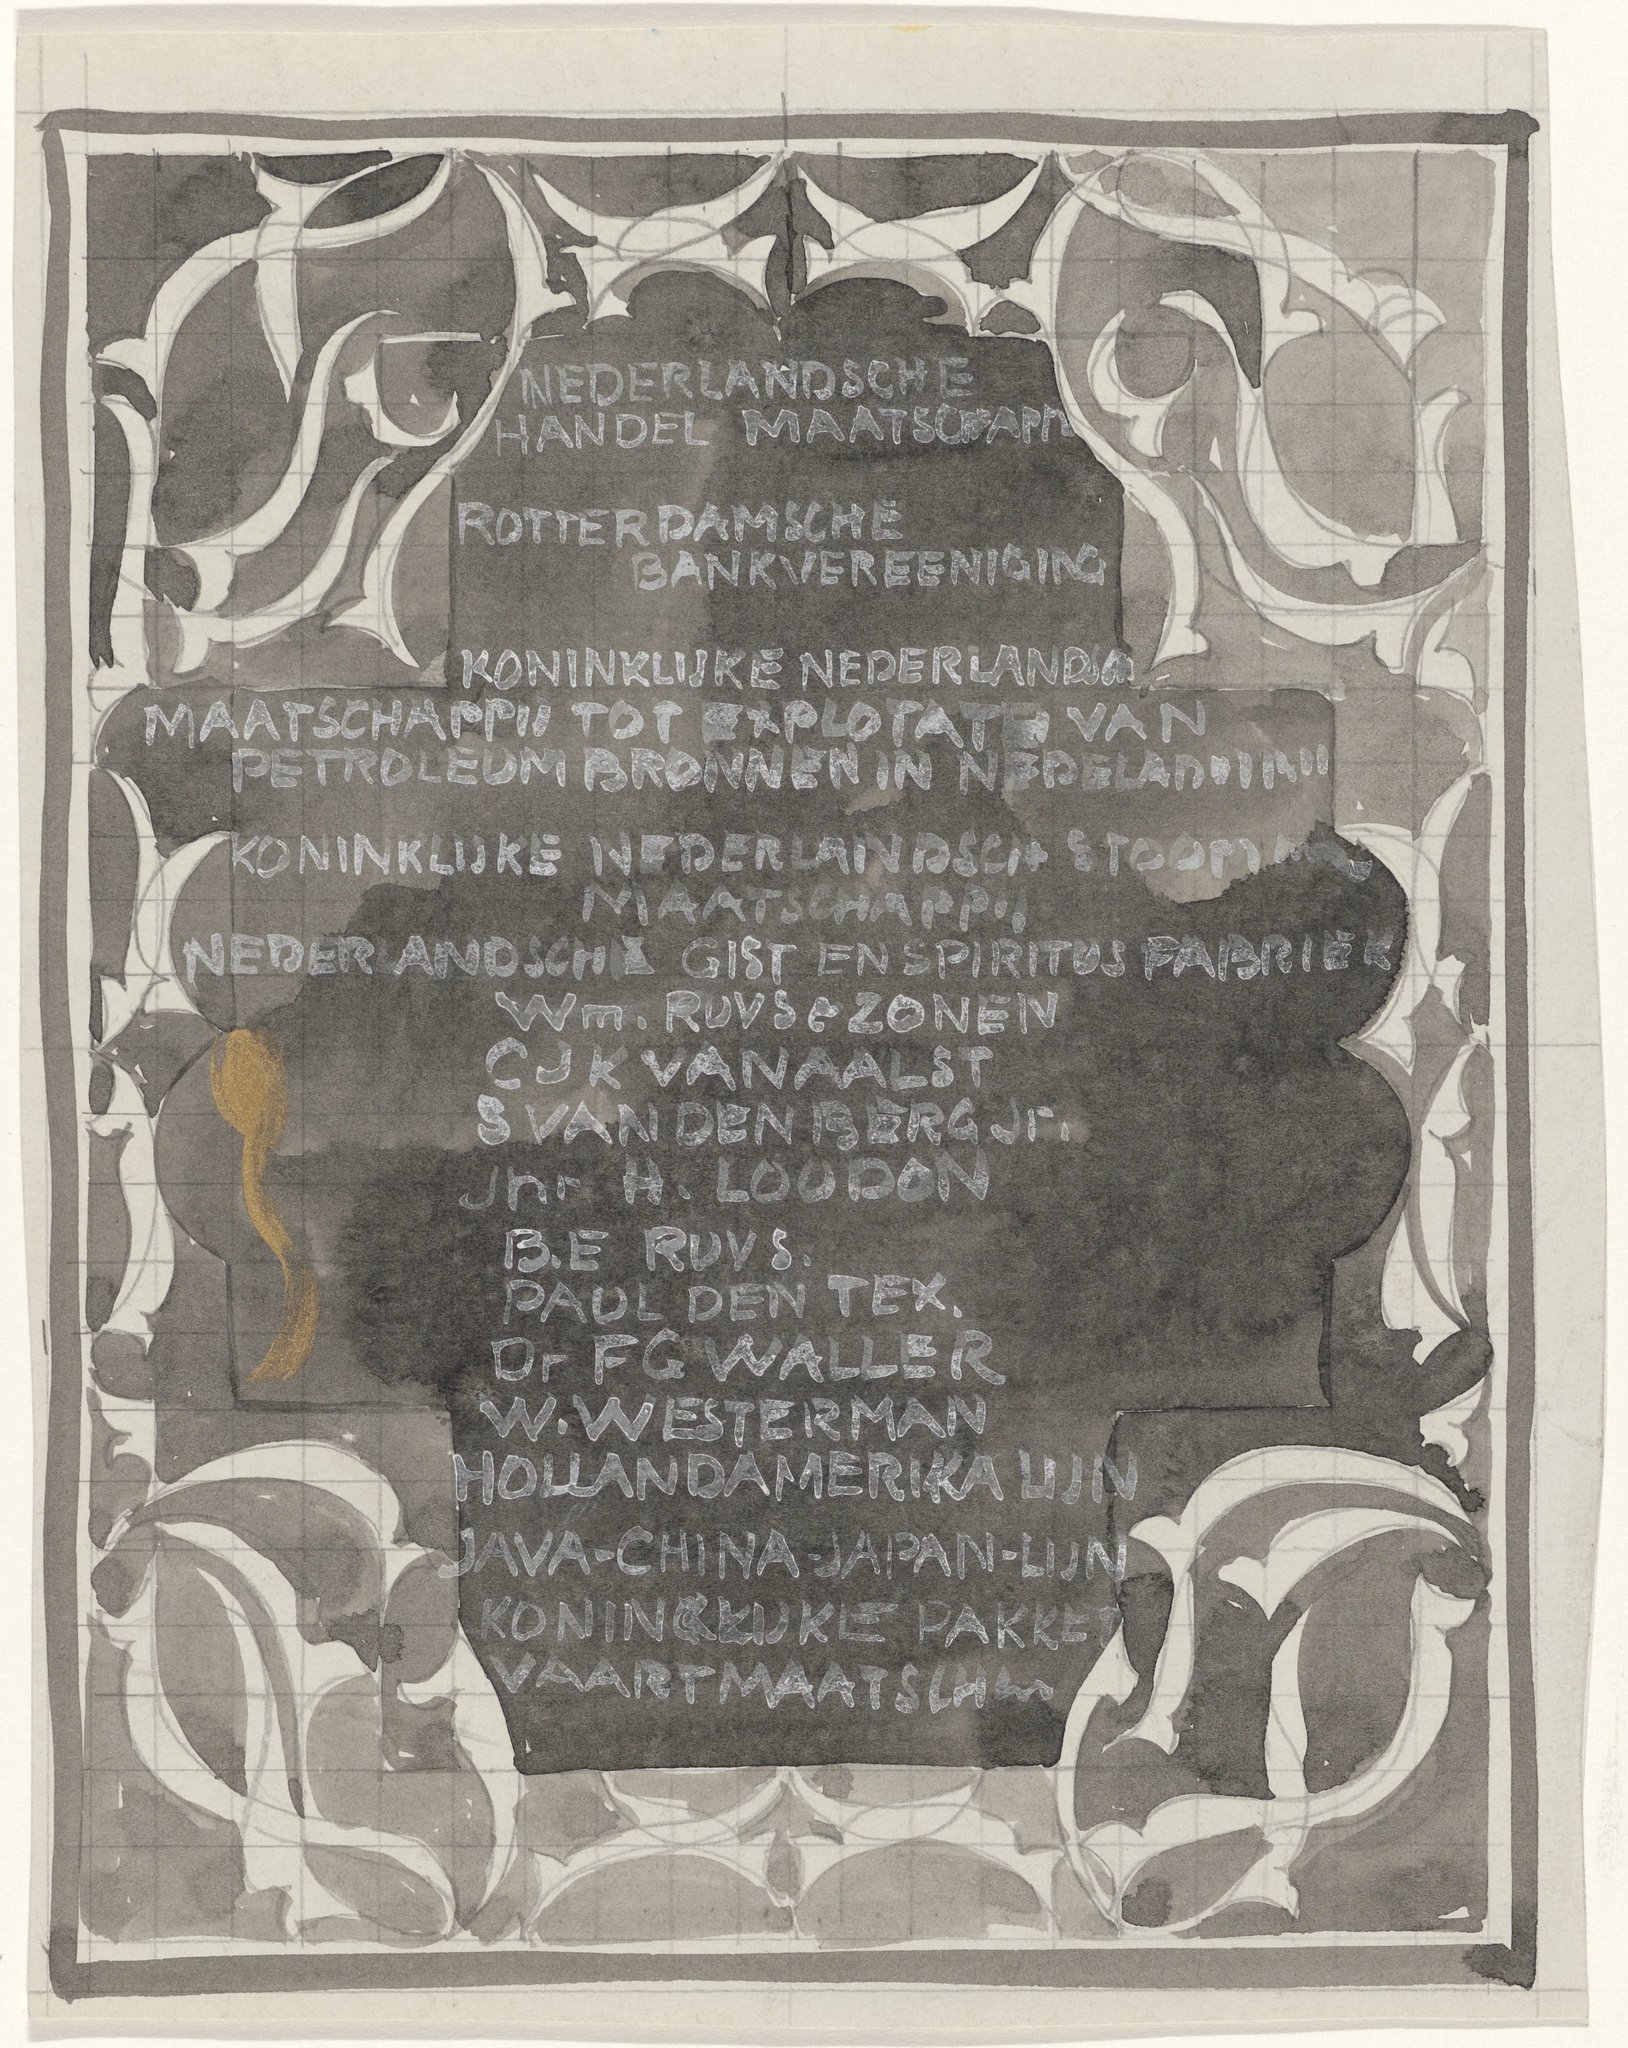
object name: drawing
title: Ornamentaal ontwerp met namen van bedrijven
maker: carel adolph lion cachet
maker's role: draughtsman, print maker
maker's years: 1864-1945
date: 1874-1945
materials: paper, pencil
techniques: brush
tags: advertising